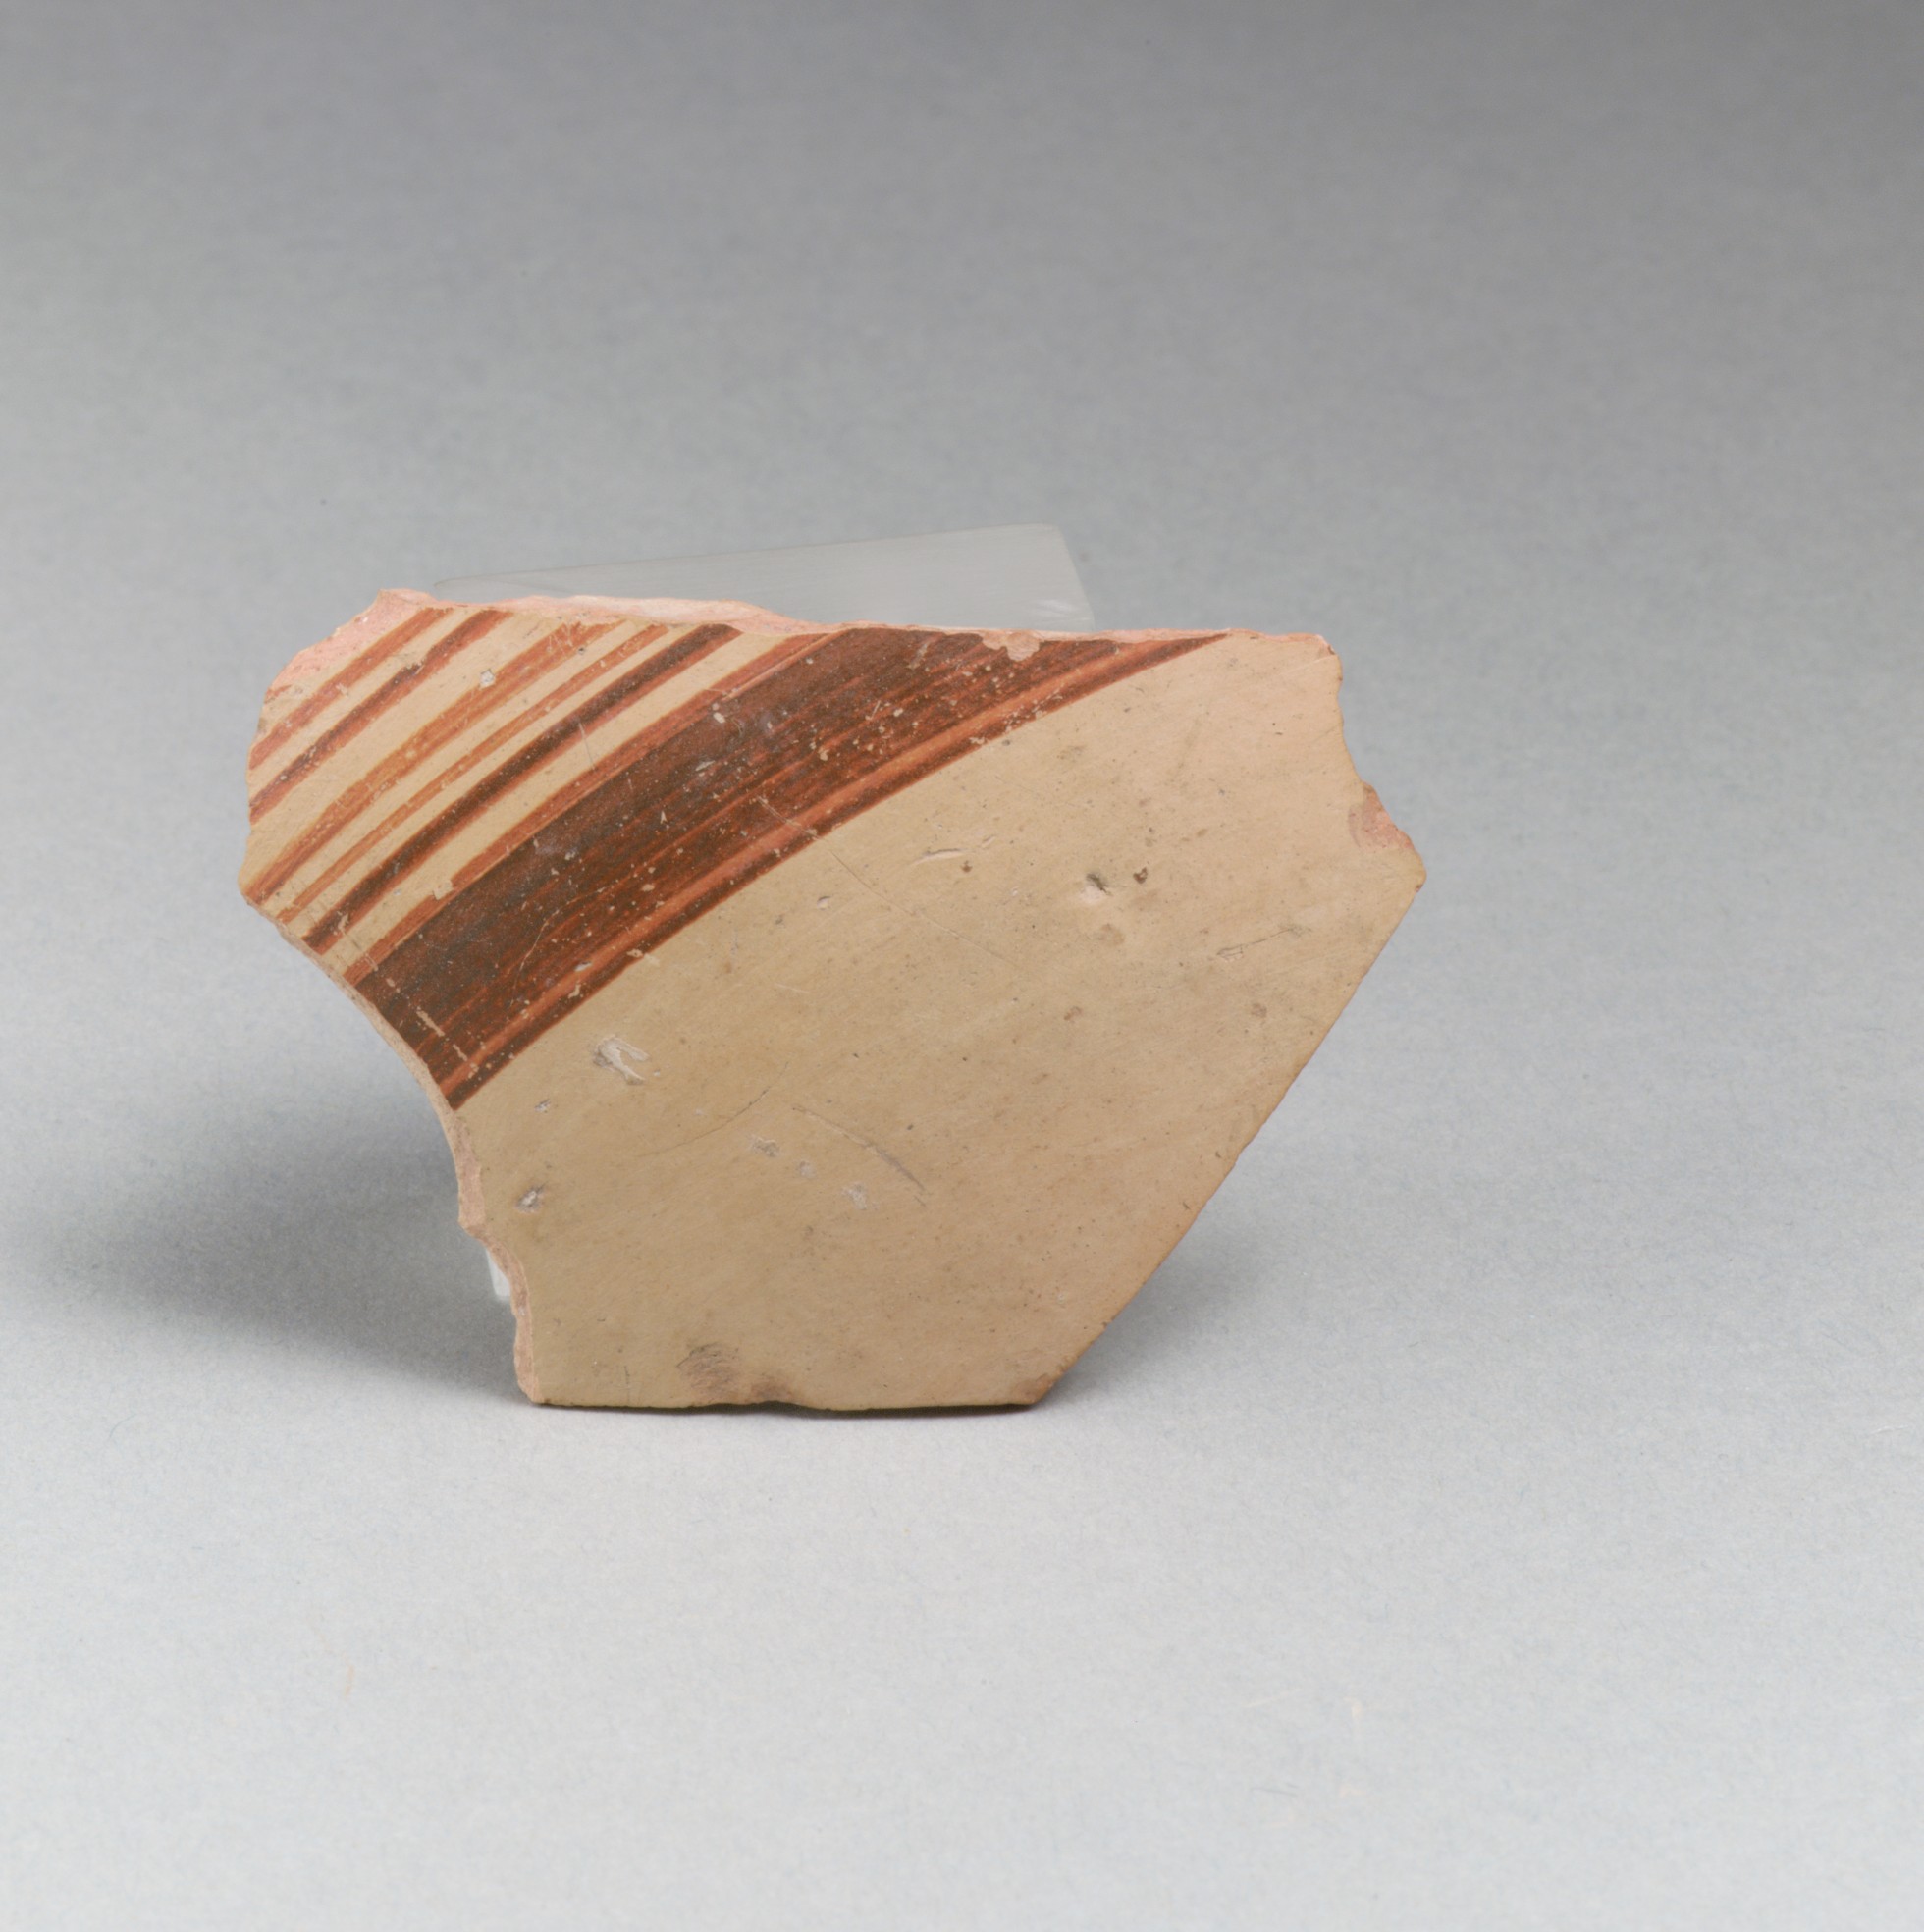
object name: vase fragment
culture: mycenaean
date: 1400-1300 BCE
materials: terracotta